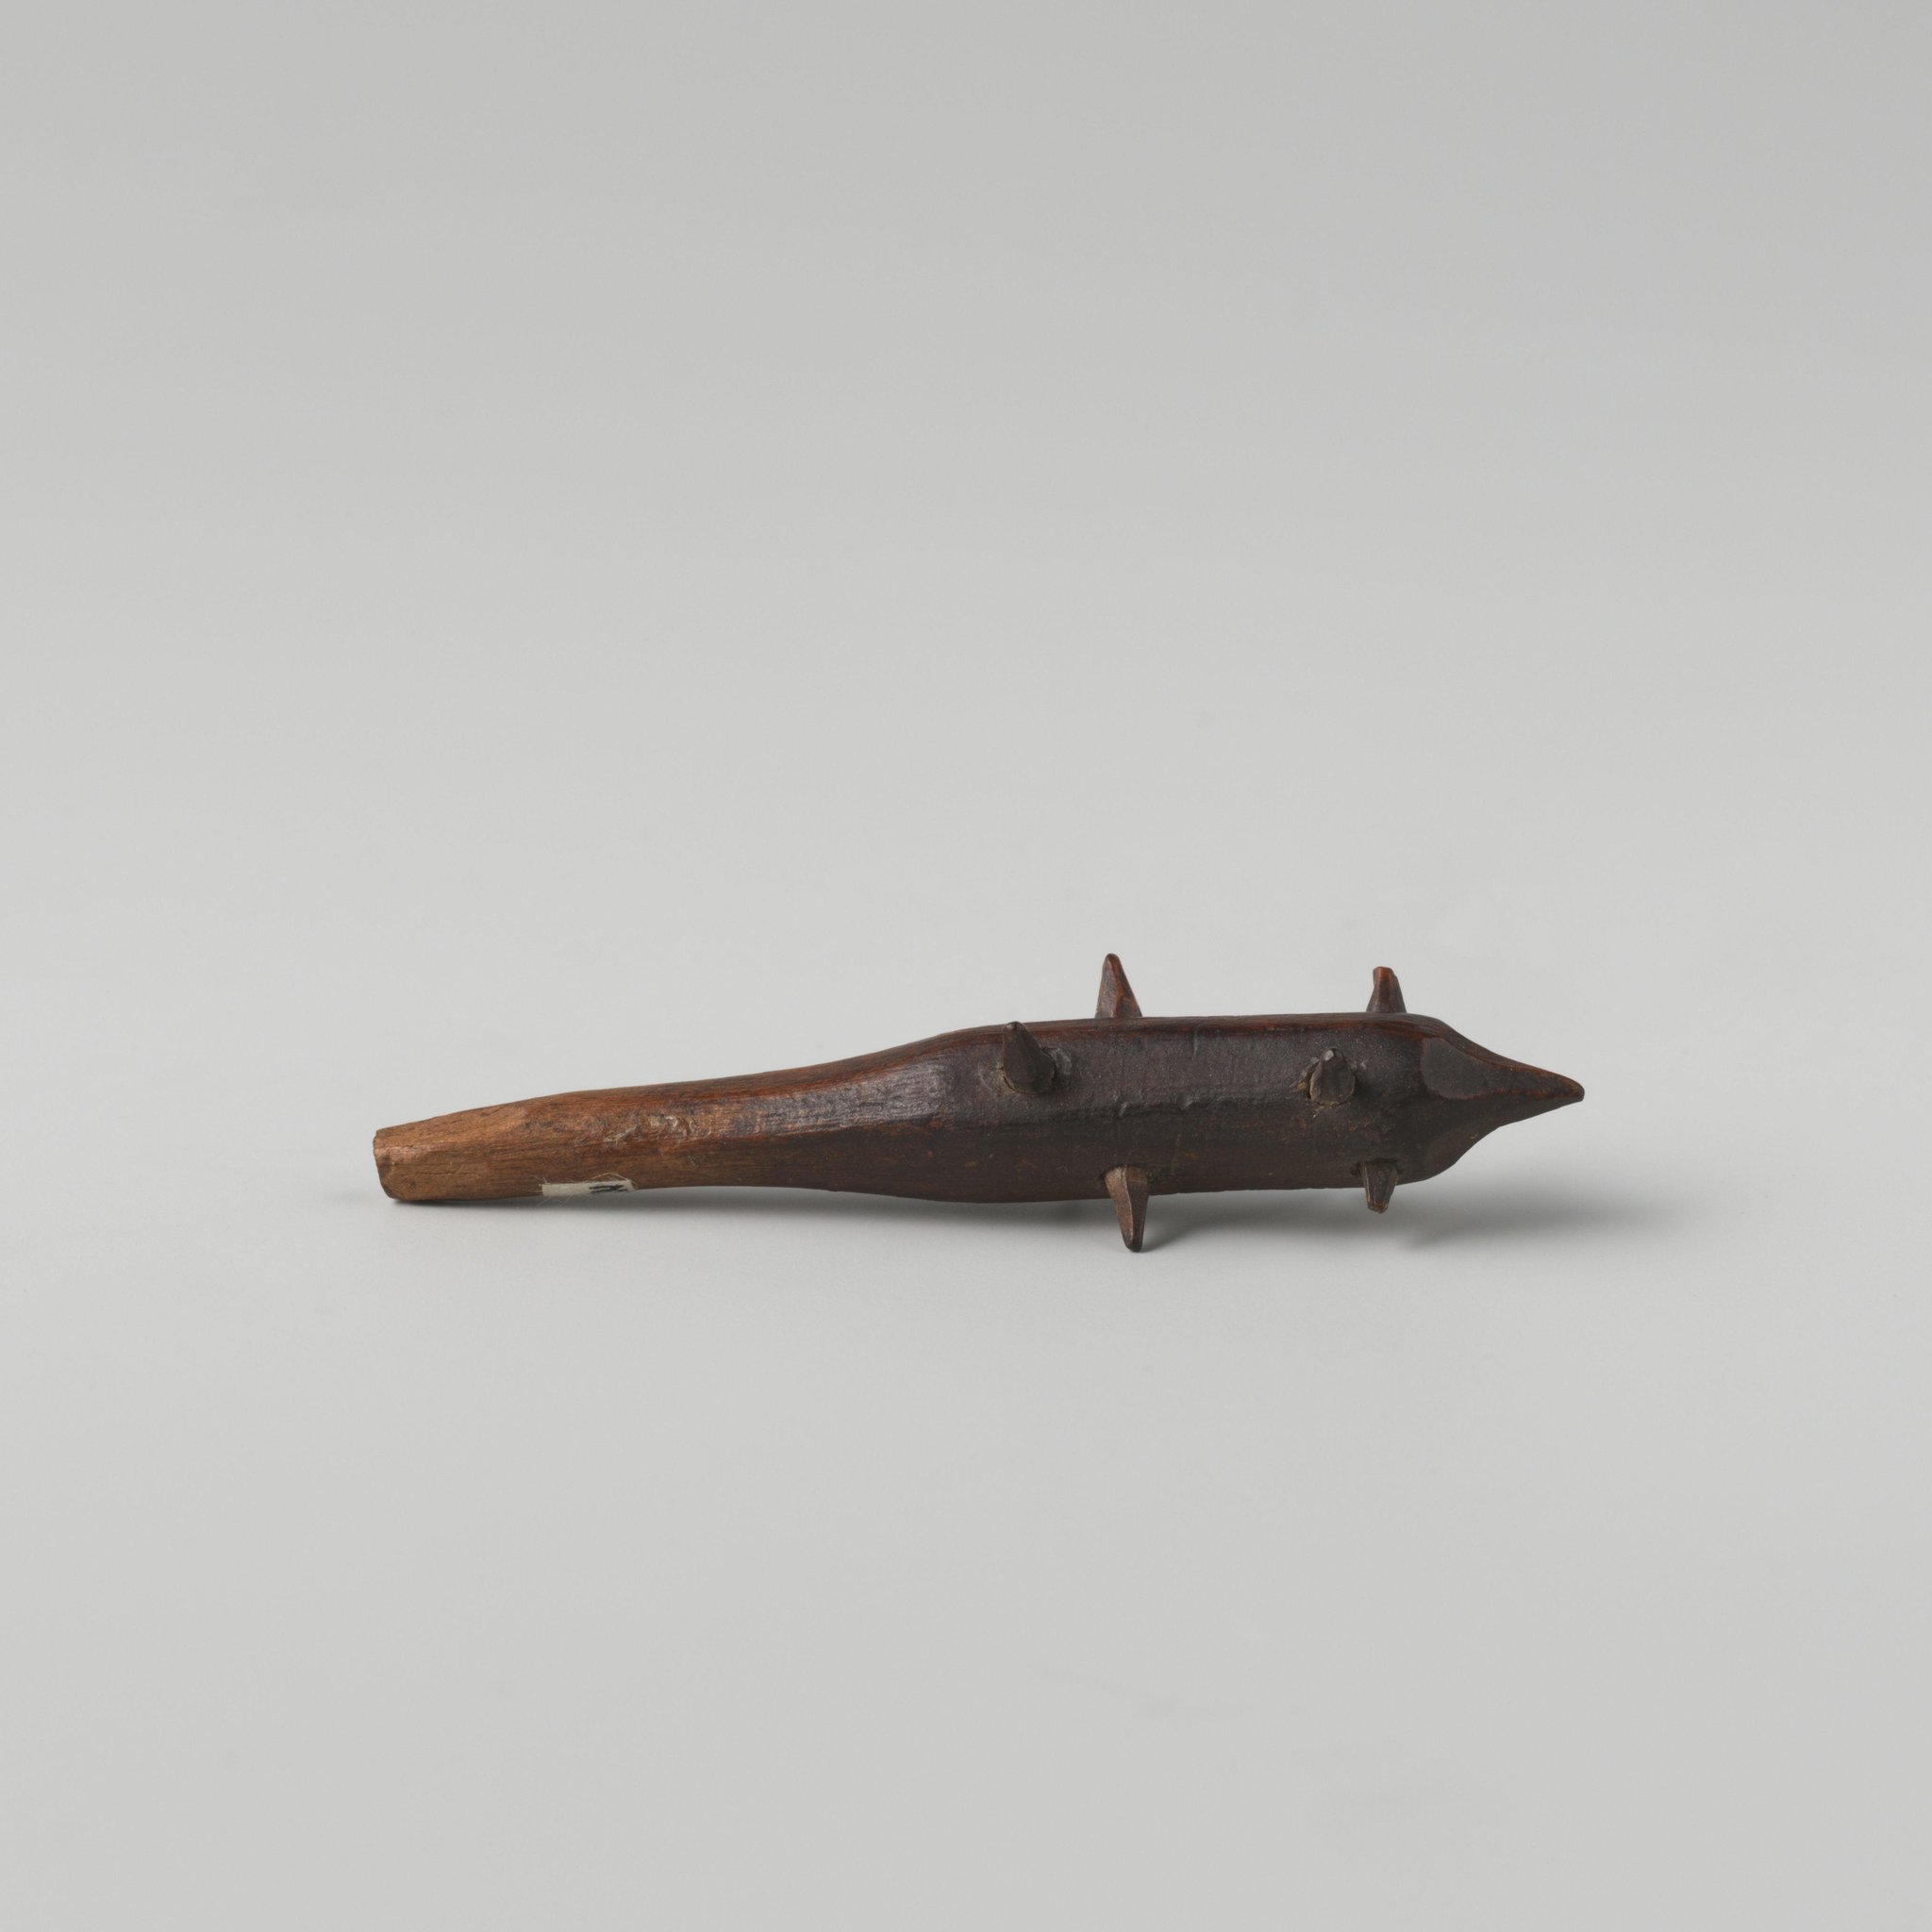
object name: club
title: Knotsvormig voorwerp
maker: Anonymous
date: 1690-1710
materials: wood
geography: amsterdam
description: Knotsvormig voorwerp, vervaardigd van notenhout, bestaande uit een spits eindigend stuk hout, waardoorheen vier puntige pinnen zijn gestoken. De functie van de knots is niet duidelijk.